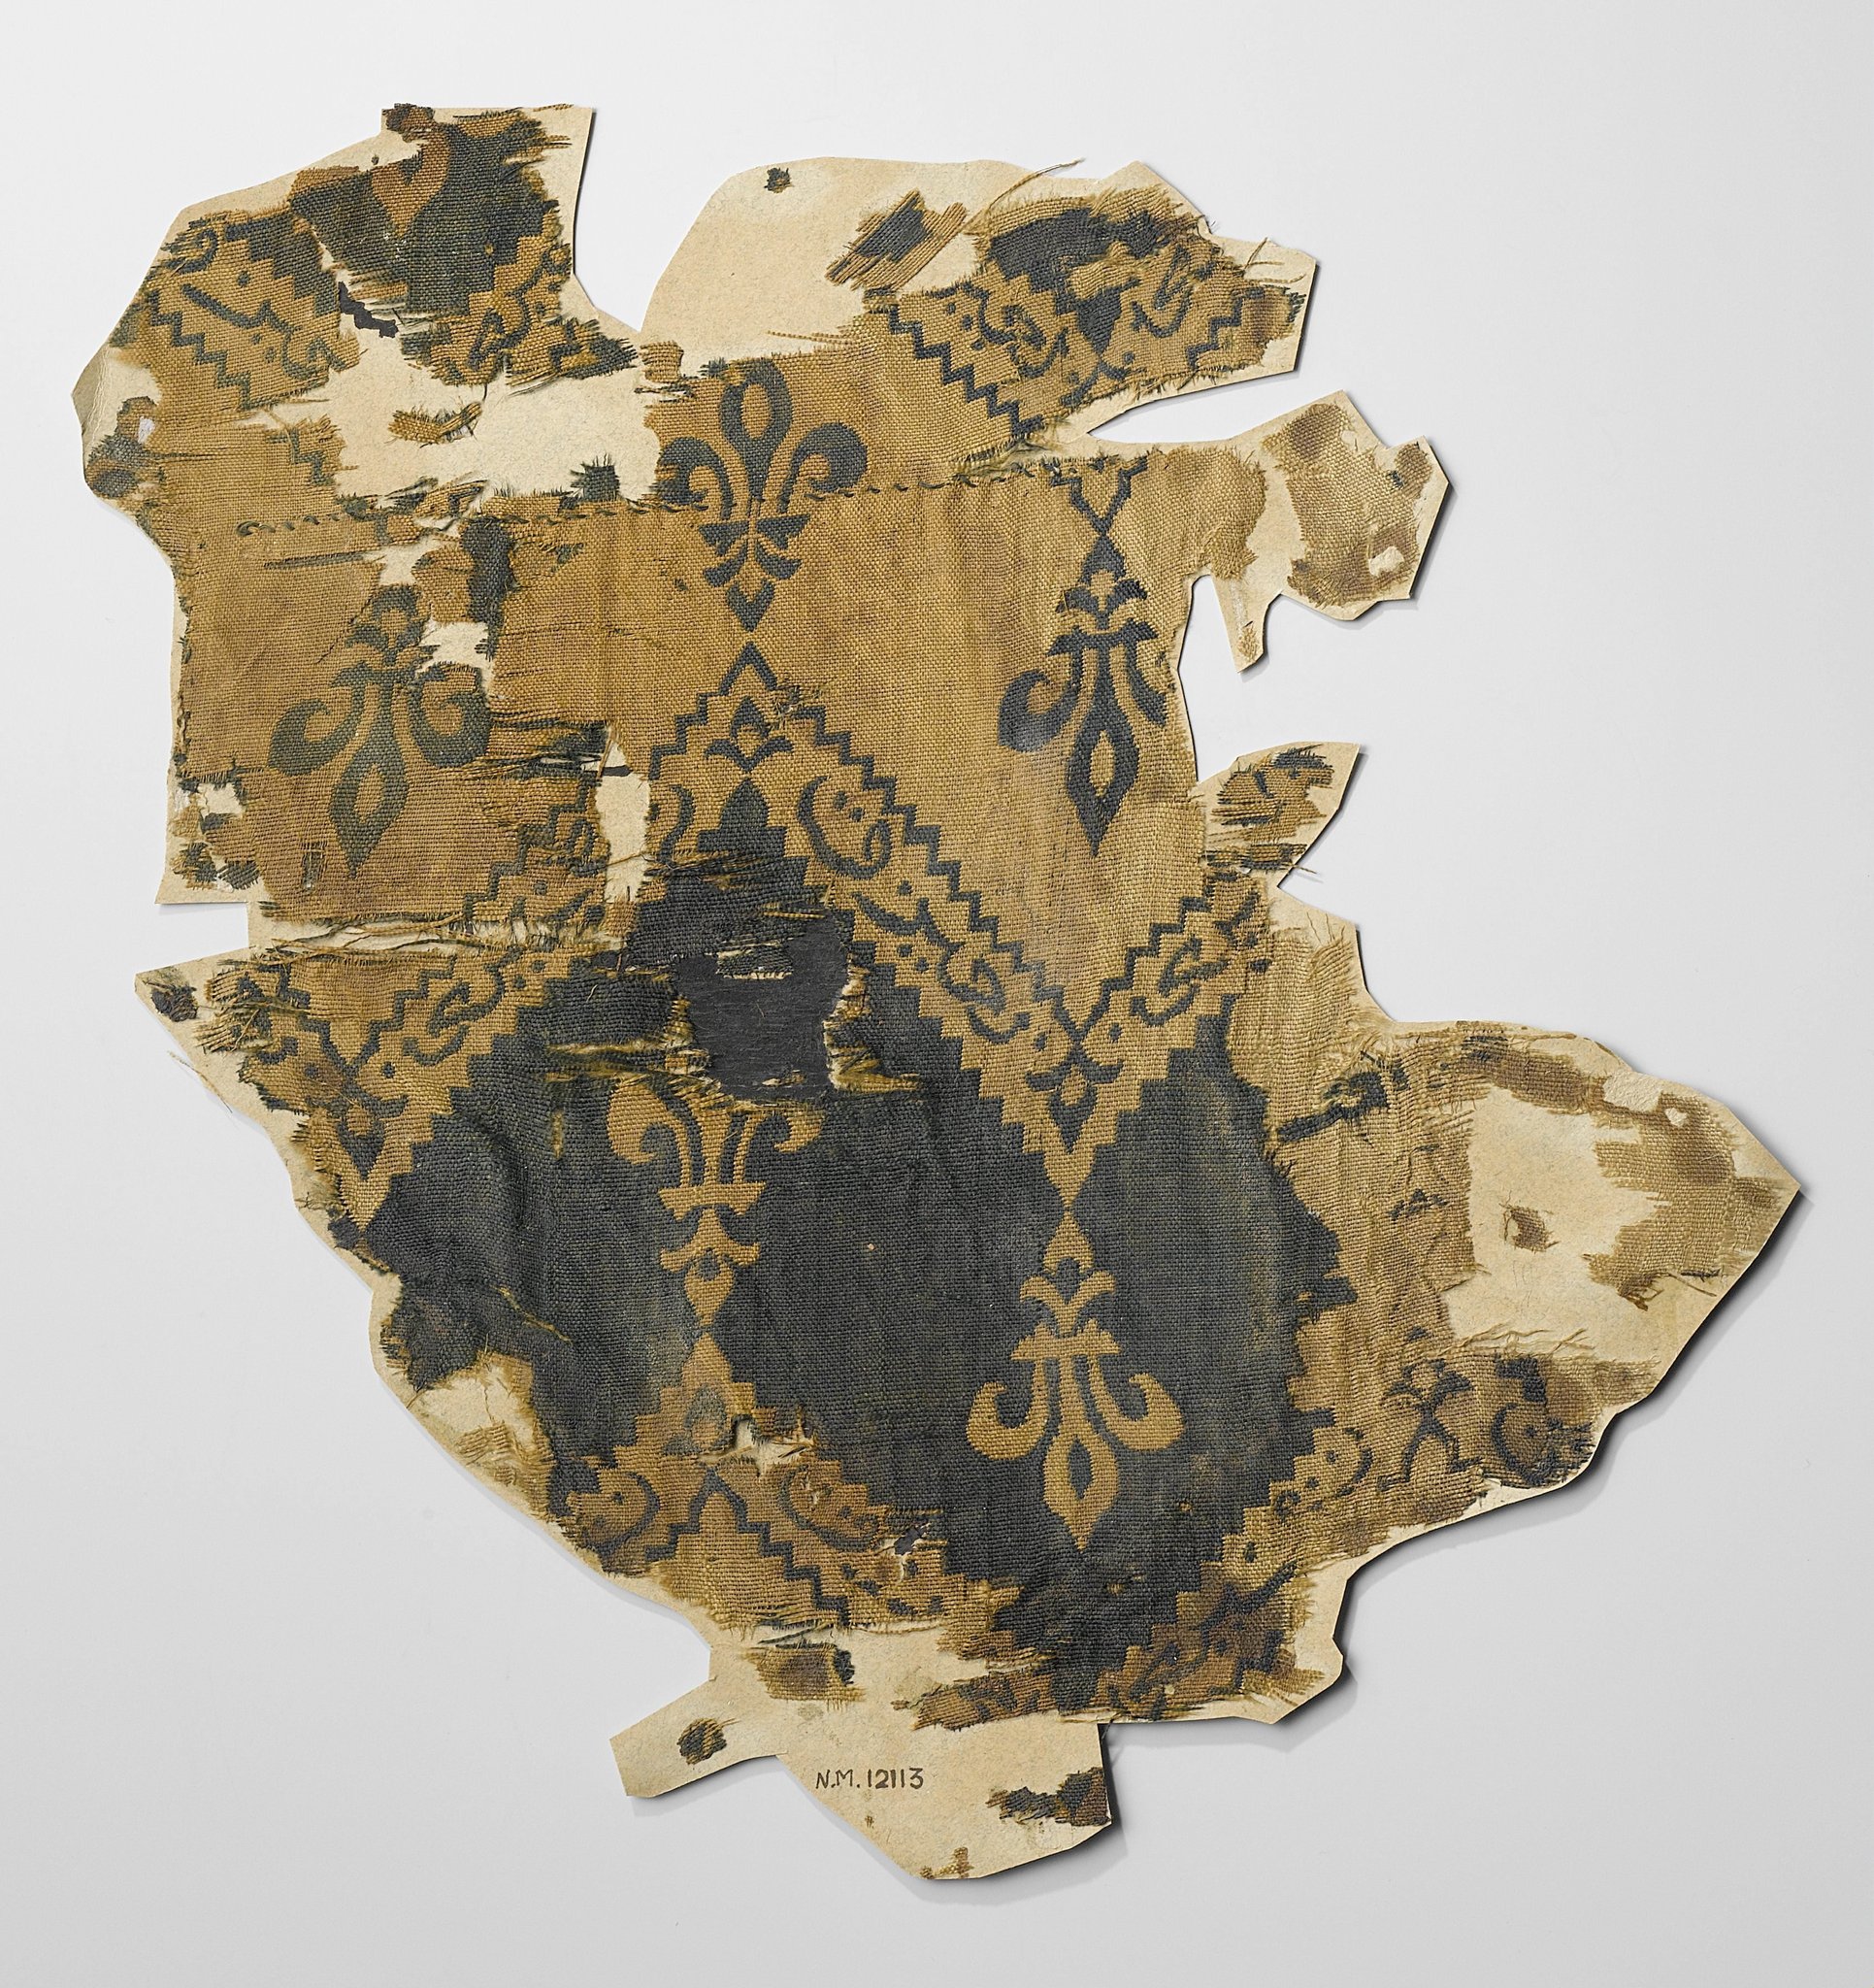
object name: woven material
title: Fragment van de 'lijkwade van Guido van Lusignan'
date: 1175-1225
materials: silk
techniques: double weave, weave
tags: guido van lusignan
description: Fragment van gele en zwarte zijde met zich herhalend patroon van fleurs de lis en zigzagbanden, afwisselend in positieve en negatieve kleuren. In de zigzagbanden Arabische letters. Incompleet rapport. Op karton geplakt.